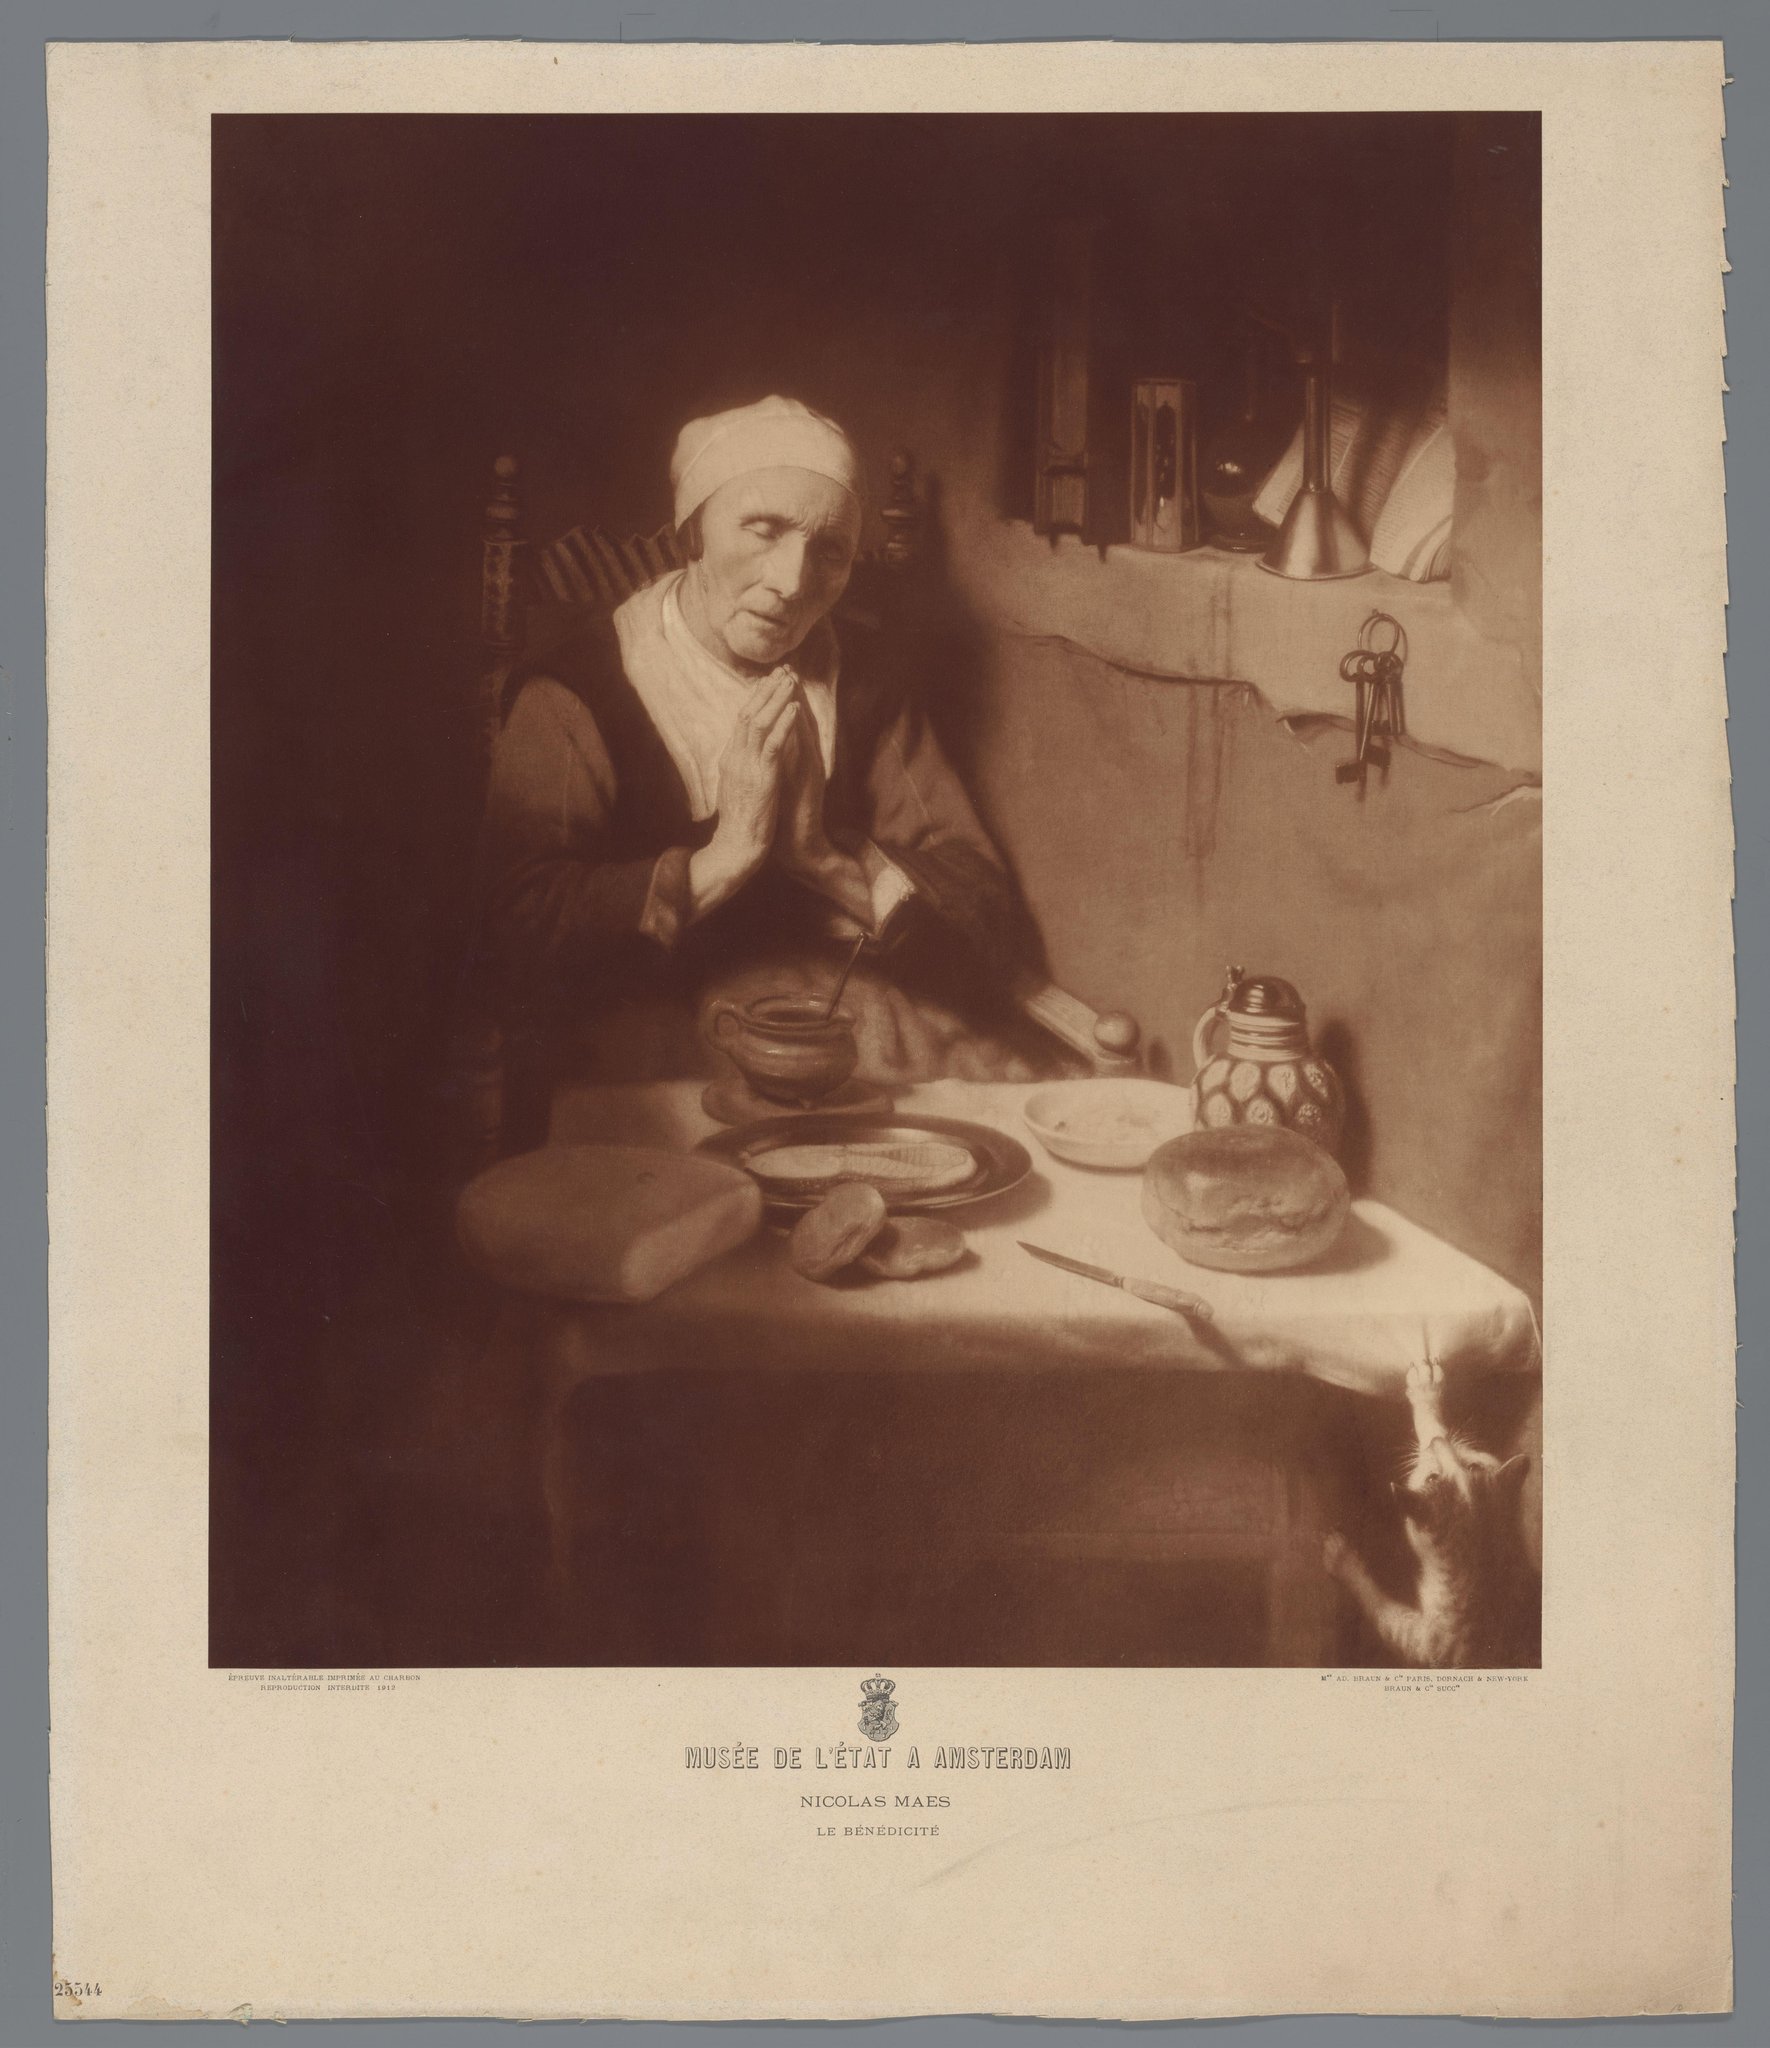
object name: photograph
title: Fotoreproductie van een schilderij van Nicolaes Maes, 'Oude vrouw in gebed' (SK-C-535) (coll. Rijksmuseum)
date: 1912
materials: cardboard, paper, photographic support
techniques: carbon print